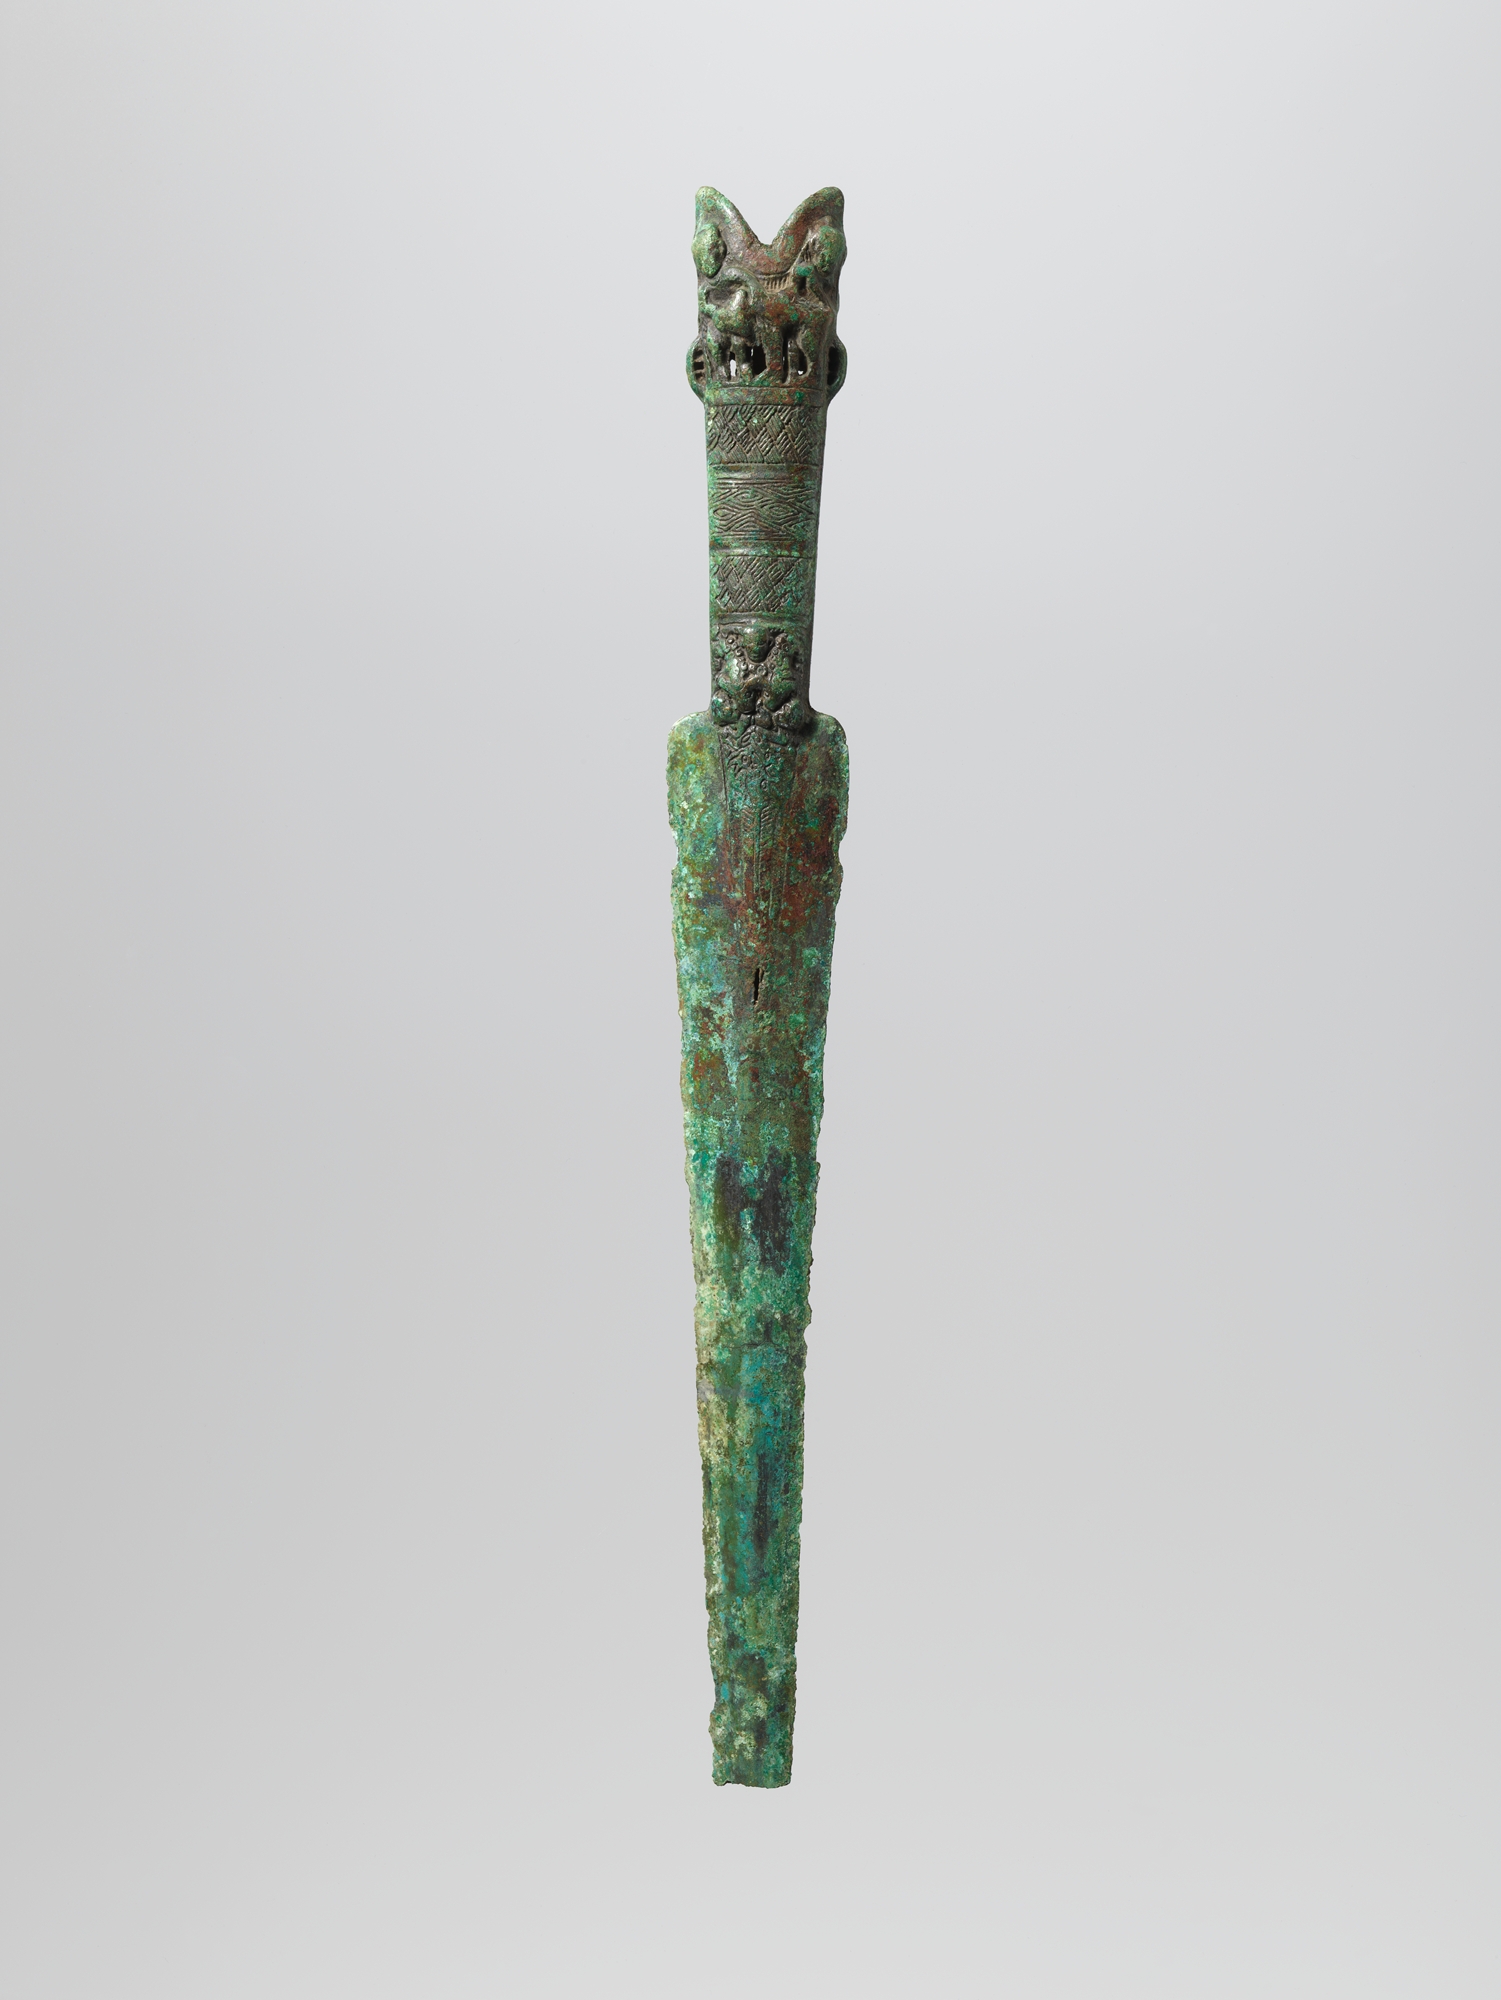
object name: spearhead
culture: chinese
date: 200-101 BCE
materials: bronze